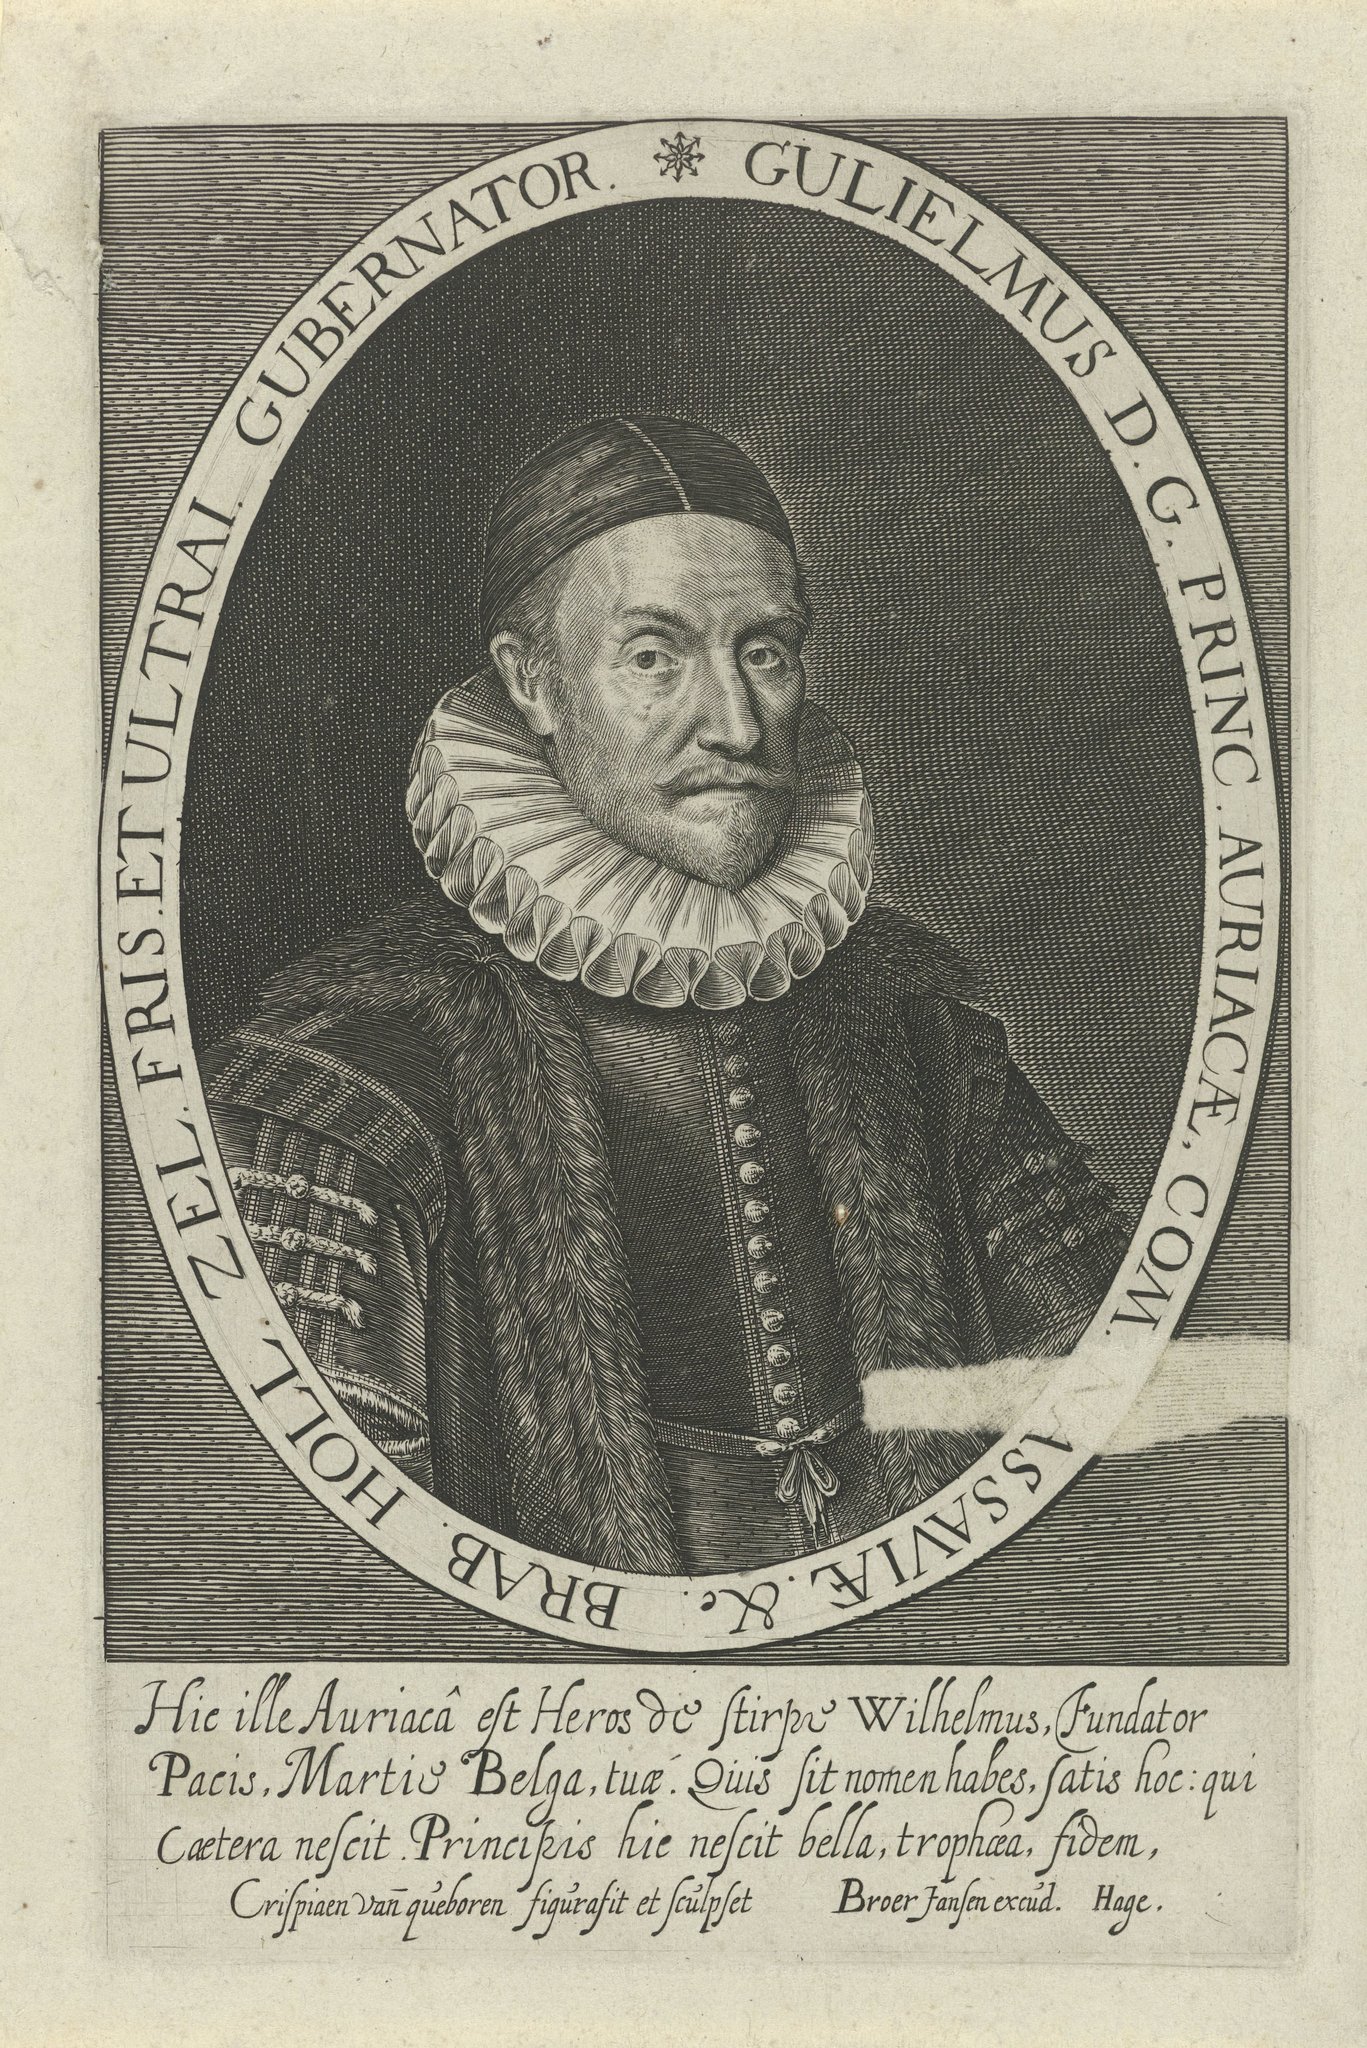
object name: print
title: Portret van Willem I, prins van Oranje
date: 1586-1629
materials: paper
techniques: engraving, etching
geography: the hague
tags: delft, william i (prince of orange)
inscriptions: collector's mark: Lugt 240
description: De hier vermelde titel verwijst naar de hoogst verkregen titel van de geportretteerde, niet per se naar de titel die de geportretteerde op deze voorstelling draagt.